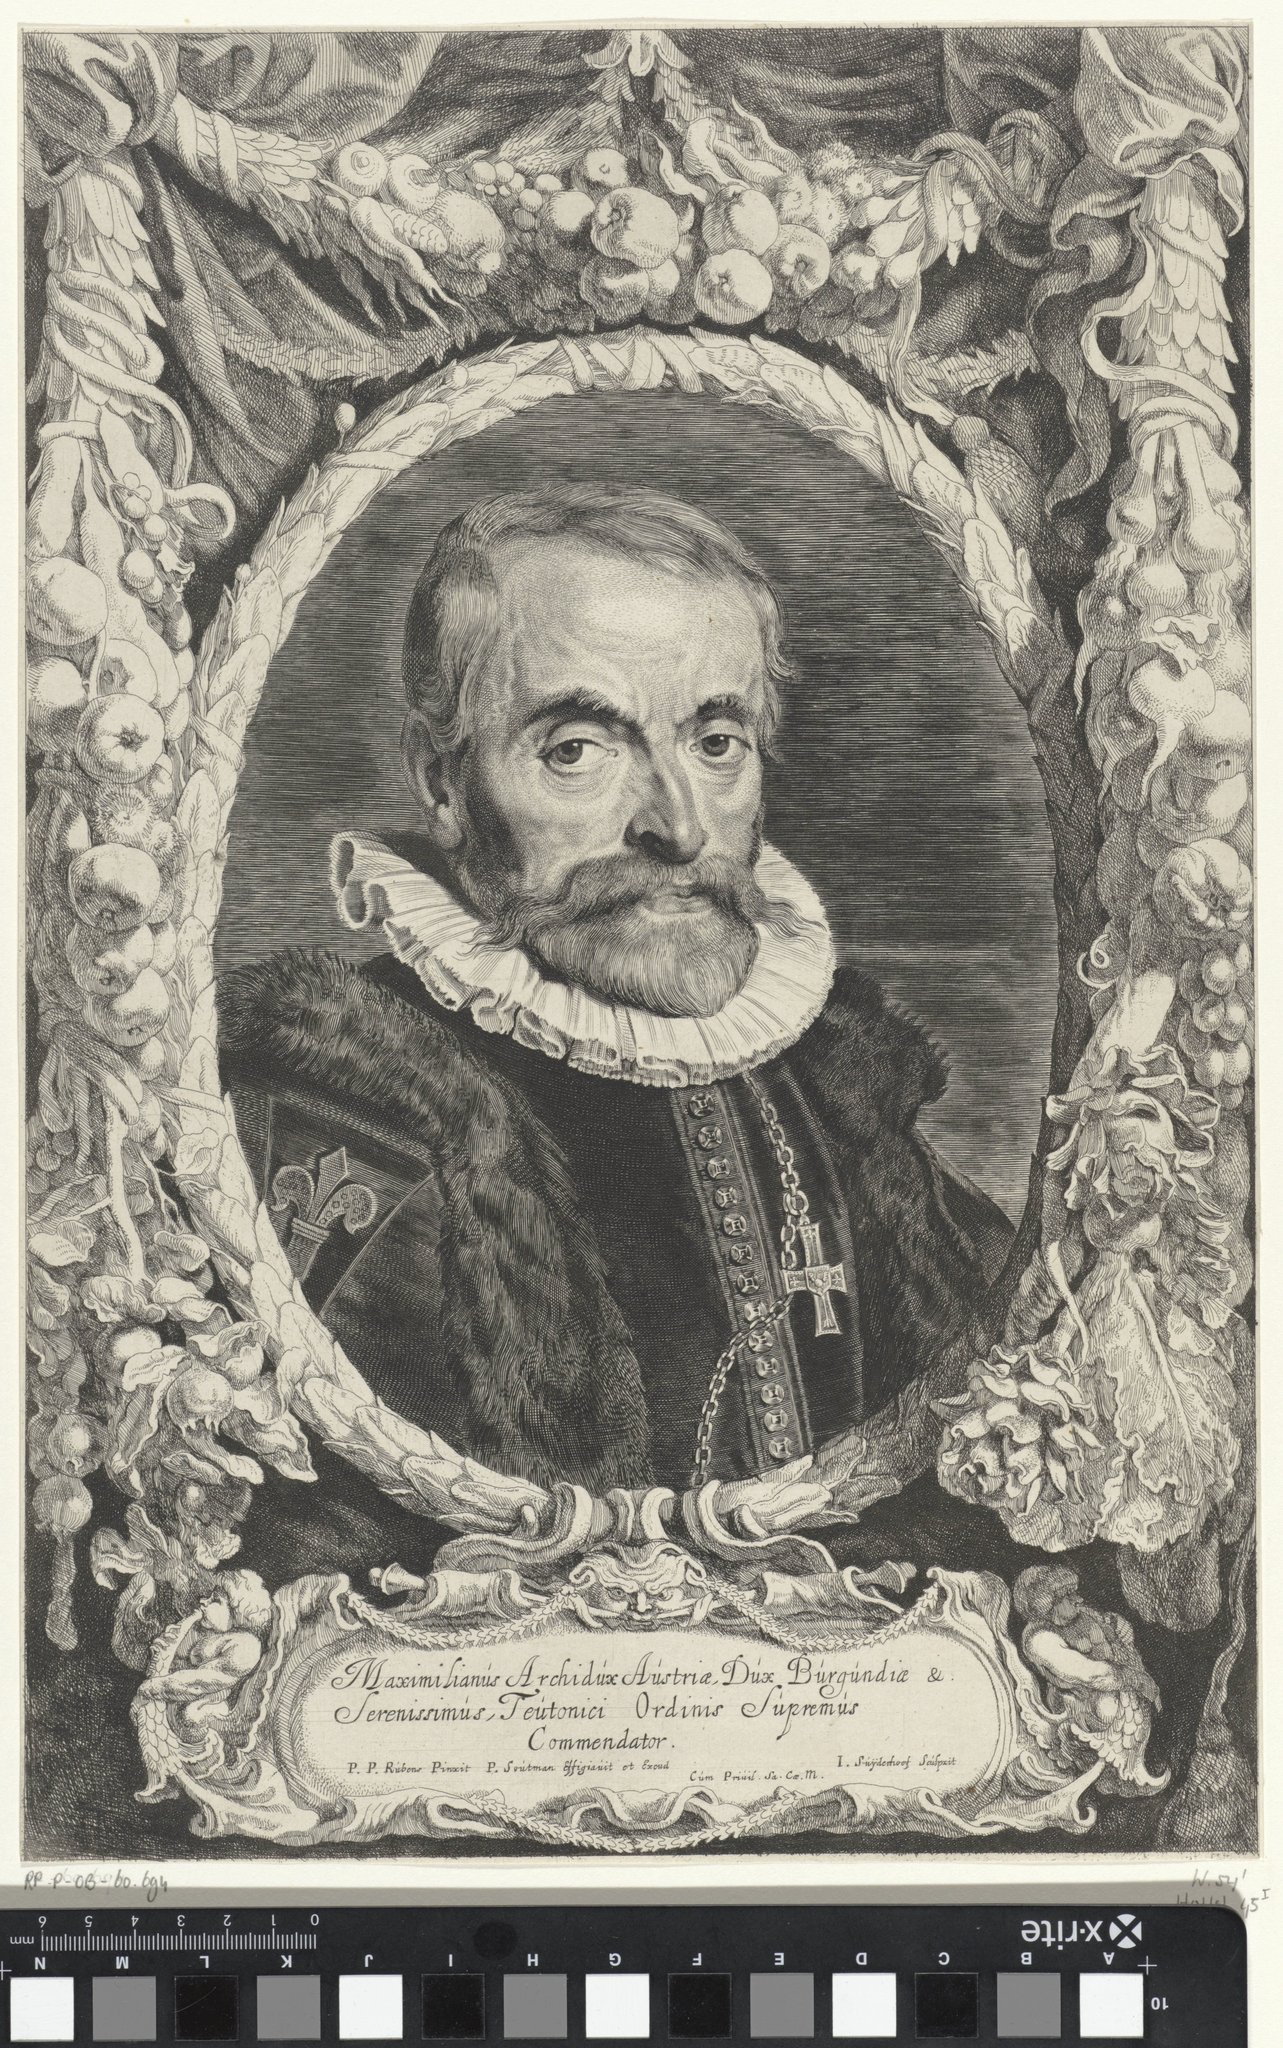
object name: print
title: Ferdinandus II[us] et III[us] Imperatorum Domus Austriacae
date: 1644-1650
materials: paper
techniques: engraving, etching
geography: haarlem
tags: vienna, maximiliaan iii (aartshertog van oostenrijk), knighthood order: teutonic order - insignia of a knighthood order, e.g.: badge, chain (with name of order), ornament ~ festoon, garland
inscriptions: collector's mark: Lugt 240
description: Portret van Maximiliaan III, aartshertog van Oostenrijk, met het ordeteken van de Duitse Orde op zijn borst. Het portret is gevat in een ornamentele omlijsting met guirlandes van vruchten. Midden onder een cartouche met zijn naam en titel in het Latijn.